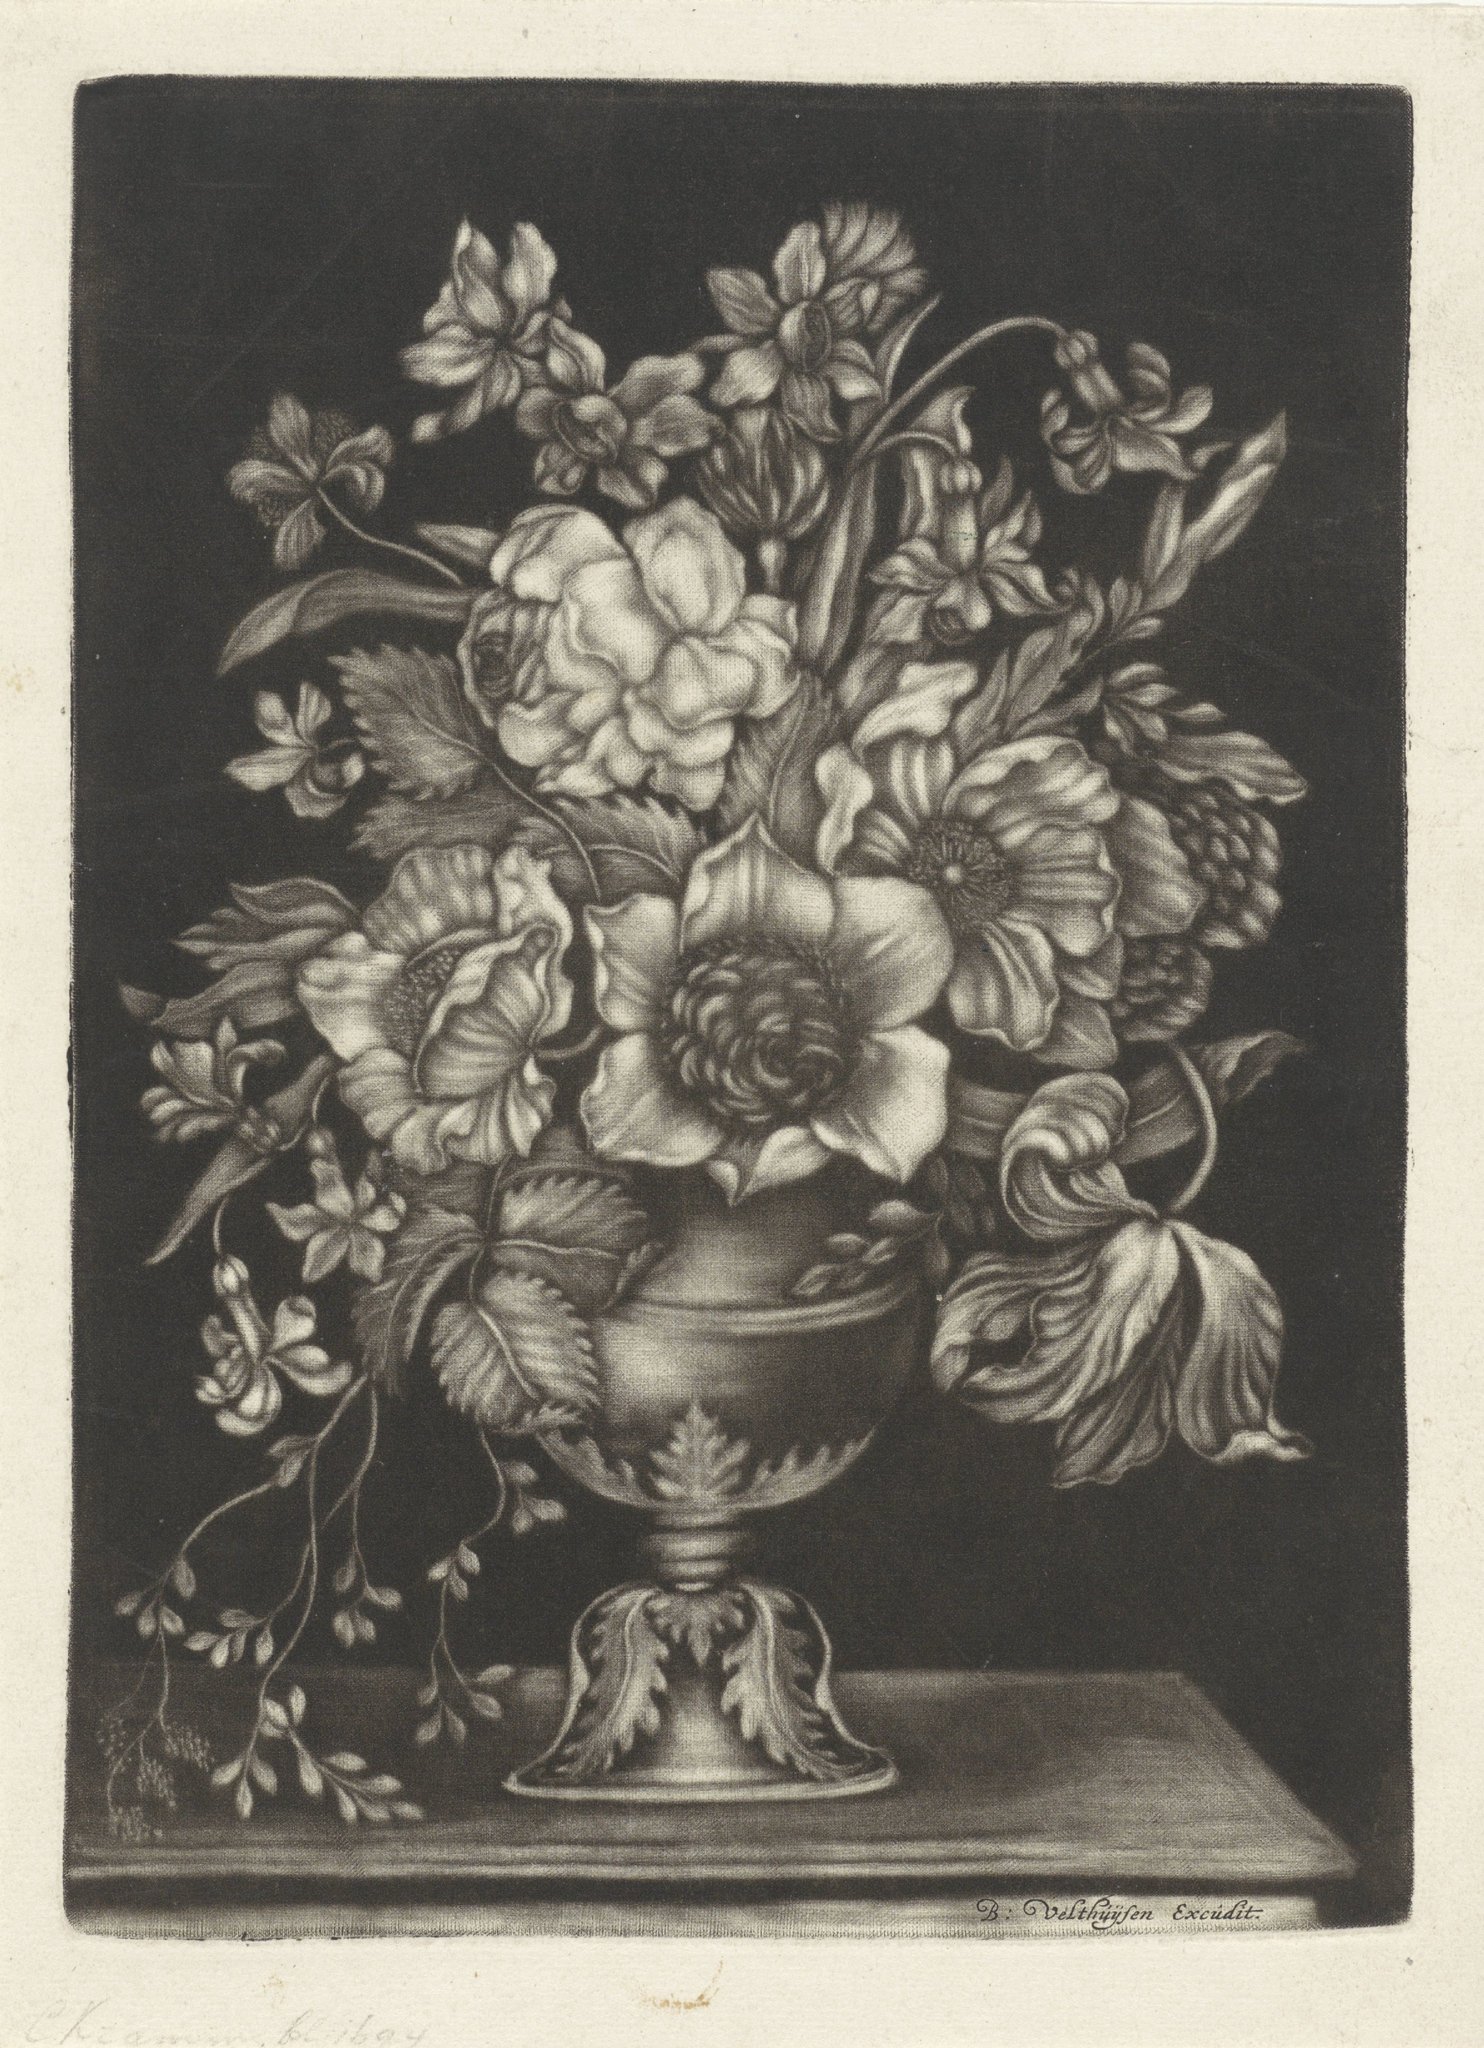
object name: print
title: Vaas met bloemen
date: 1700-1750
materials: paper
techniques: mezzotint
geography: amsterdam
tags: cut flowers; nosegay, bunch of flowers, flowers in a vase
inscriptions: collector's mark: Lugt 2228